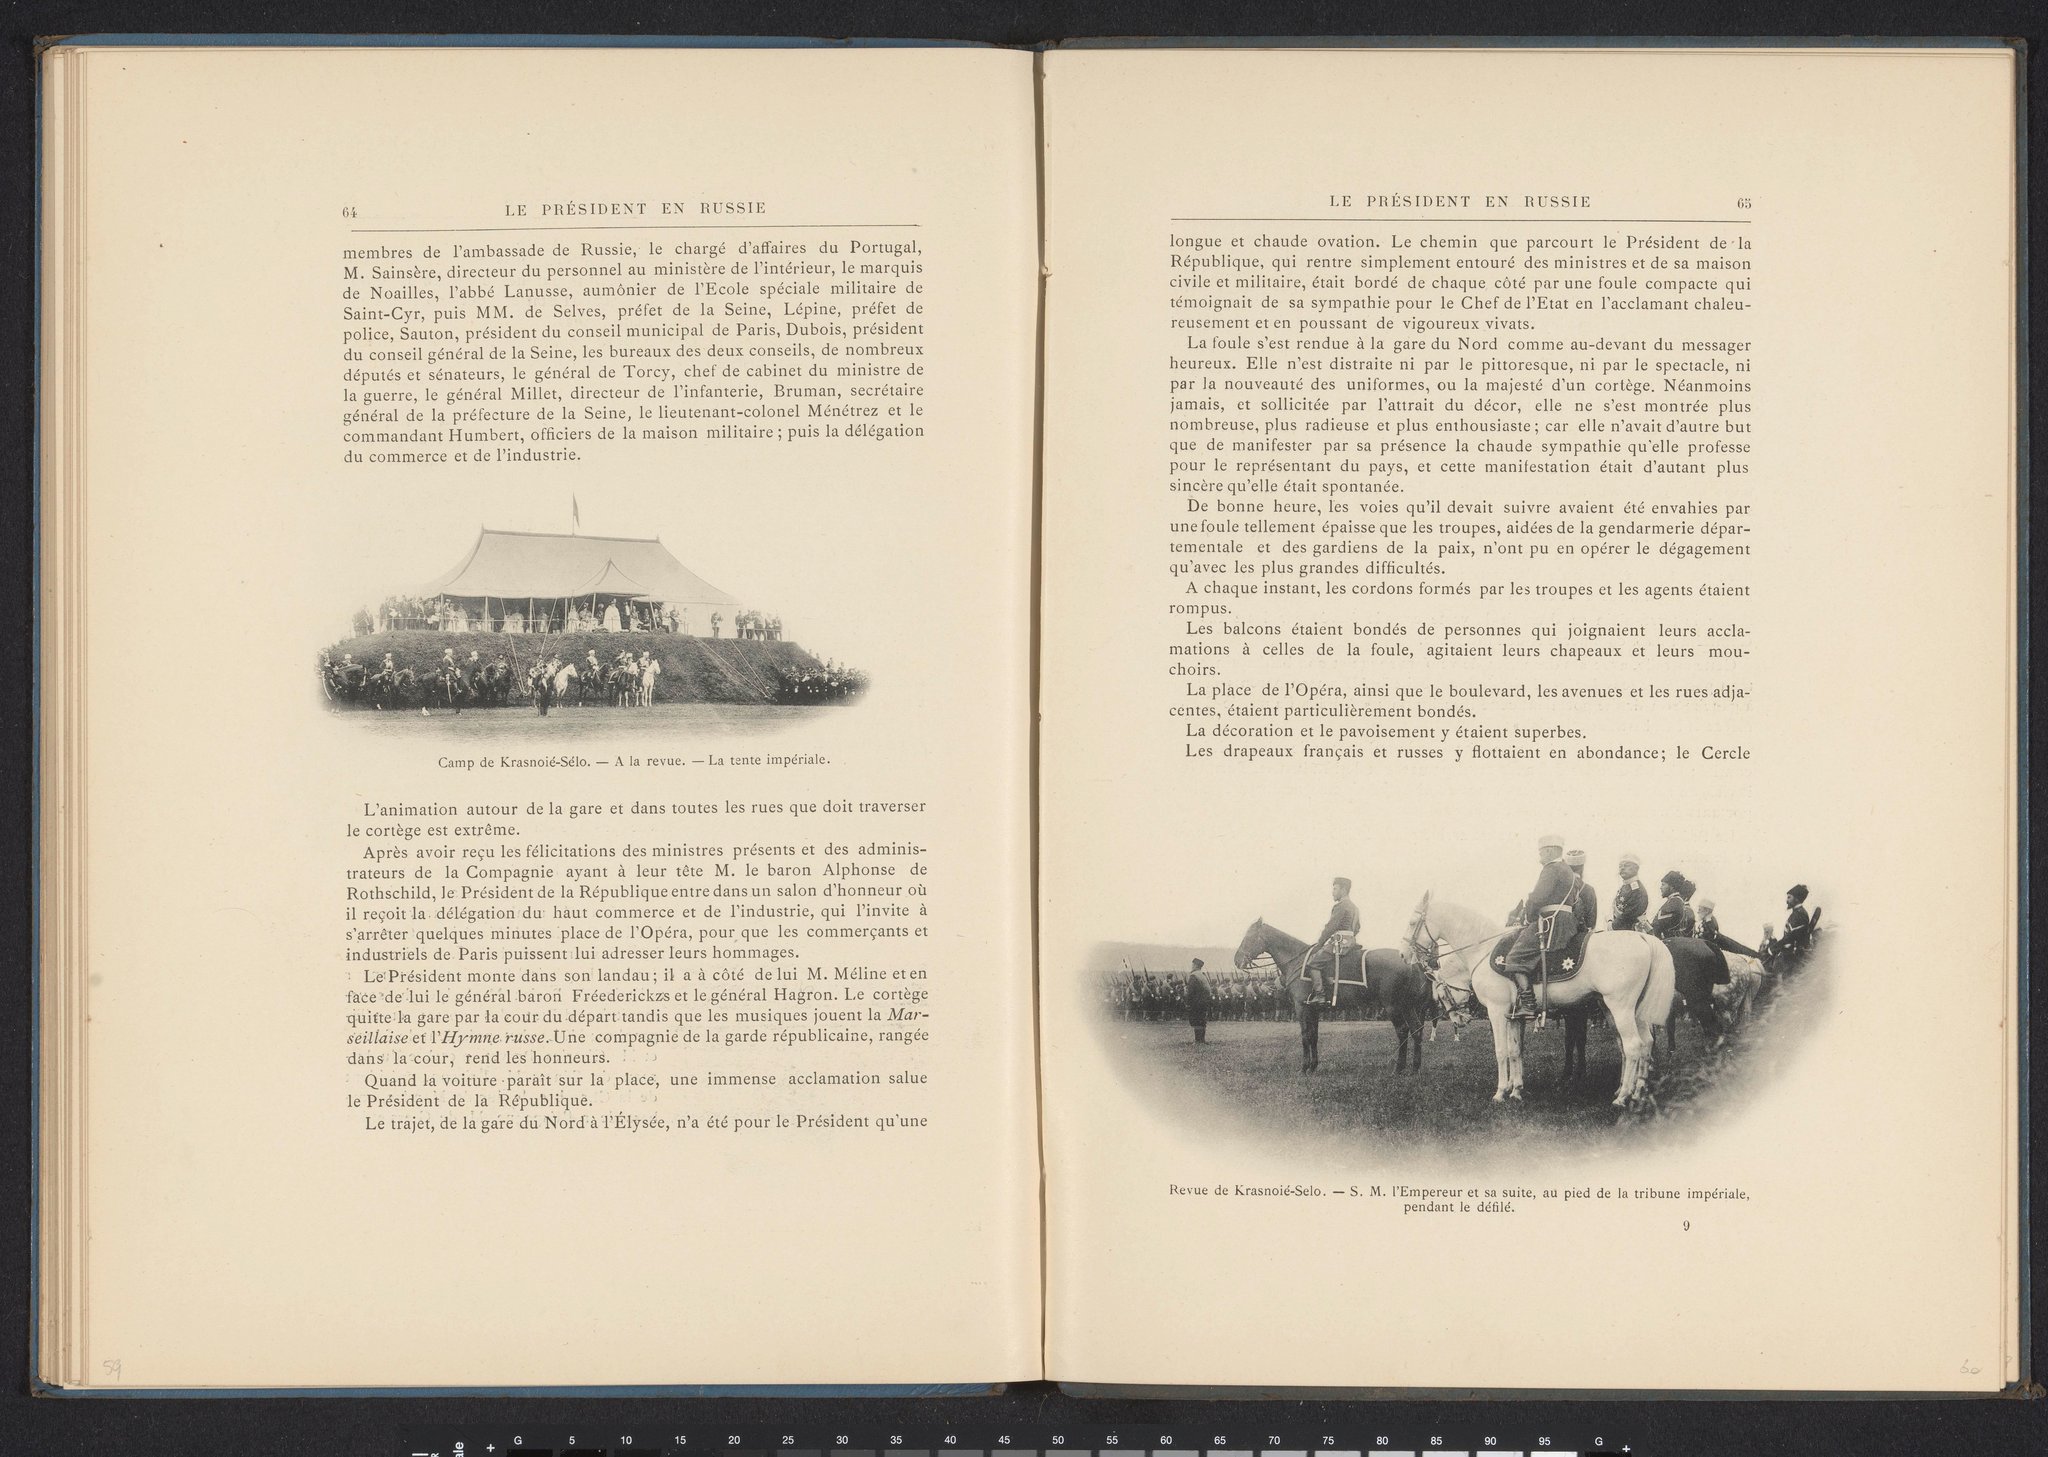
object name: page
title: Gezicht op de keizerlijke tent te Krasnoye Selo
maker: Anonymous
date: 1897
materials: paper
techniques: photograph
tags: riding a horse, ass, or mule; rider, horseman, tent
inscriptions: inscription: ‘Camp de Krasnoié-Sélo-(...) impériale.’